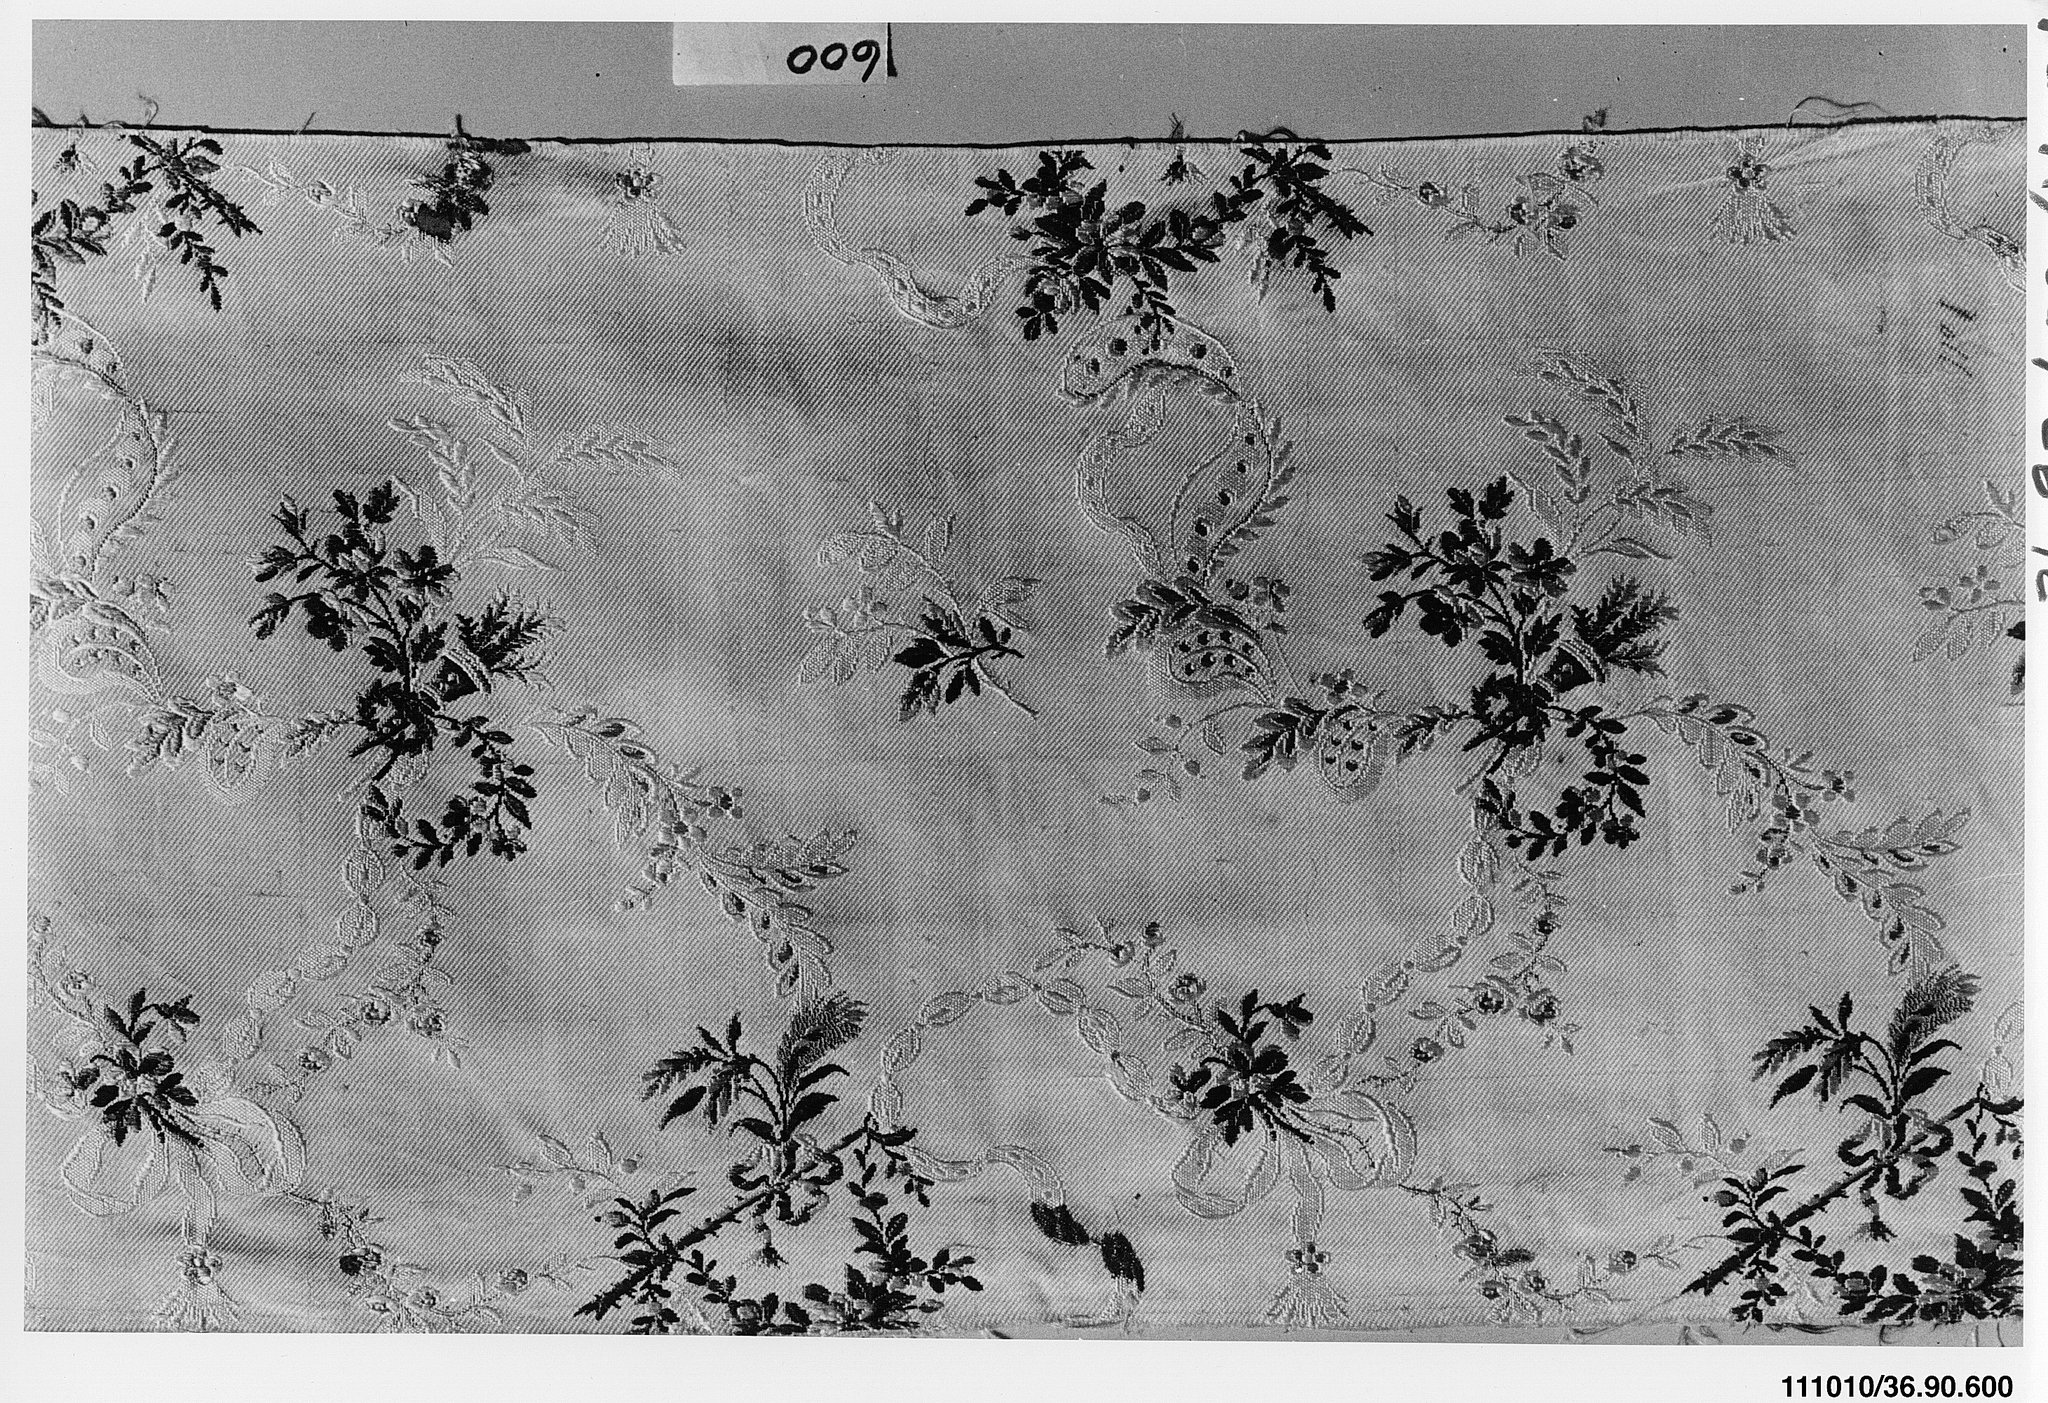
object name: piece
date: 1701-1800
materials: silk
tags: flowers,leaves